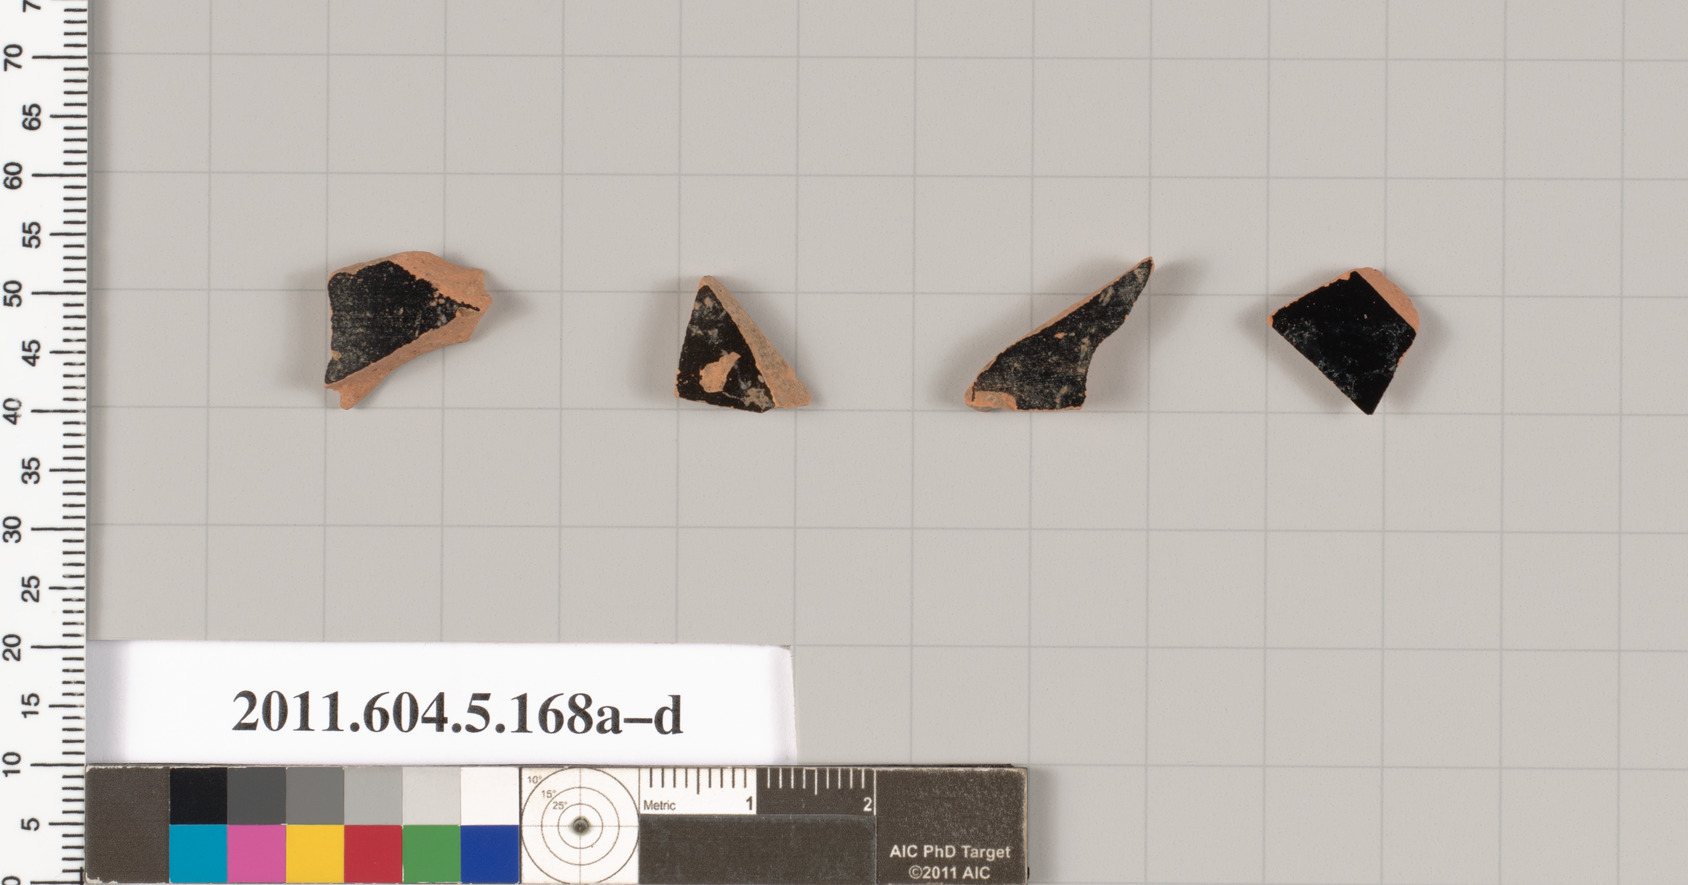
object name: kylix fragment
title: Terracotta fragments of kylikes (drinking cups)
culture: greek, attic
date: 600-401 BCE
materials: terracotta